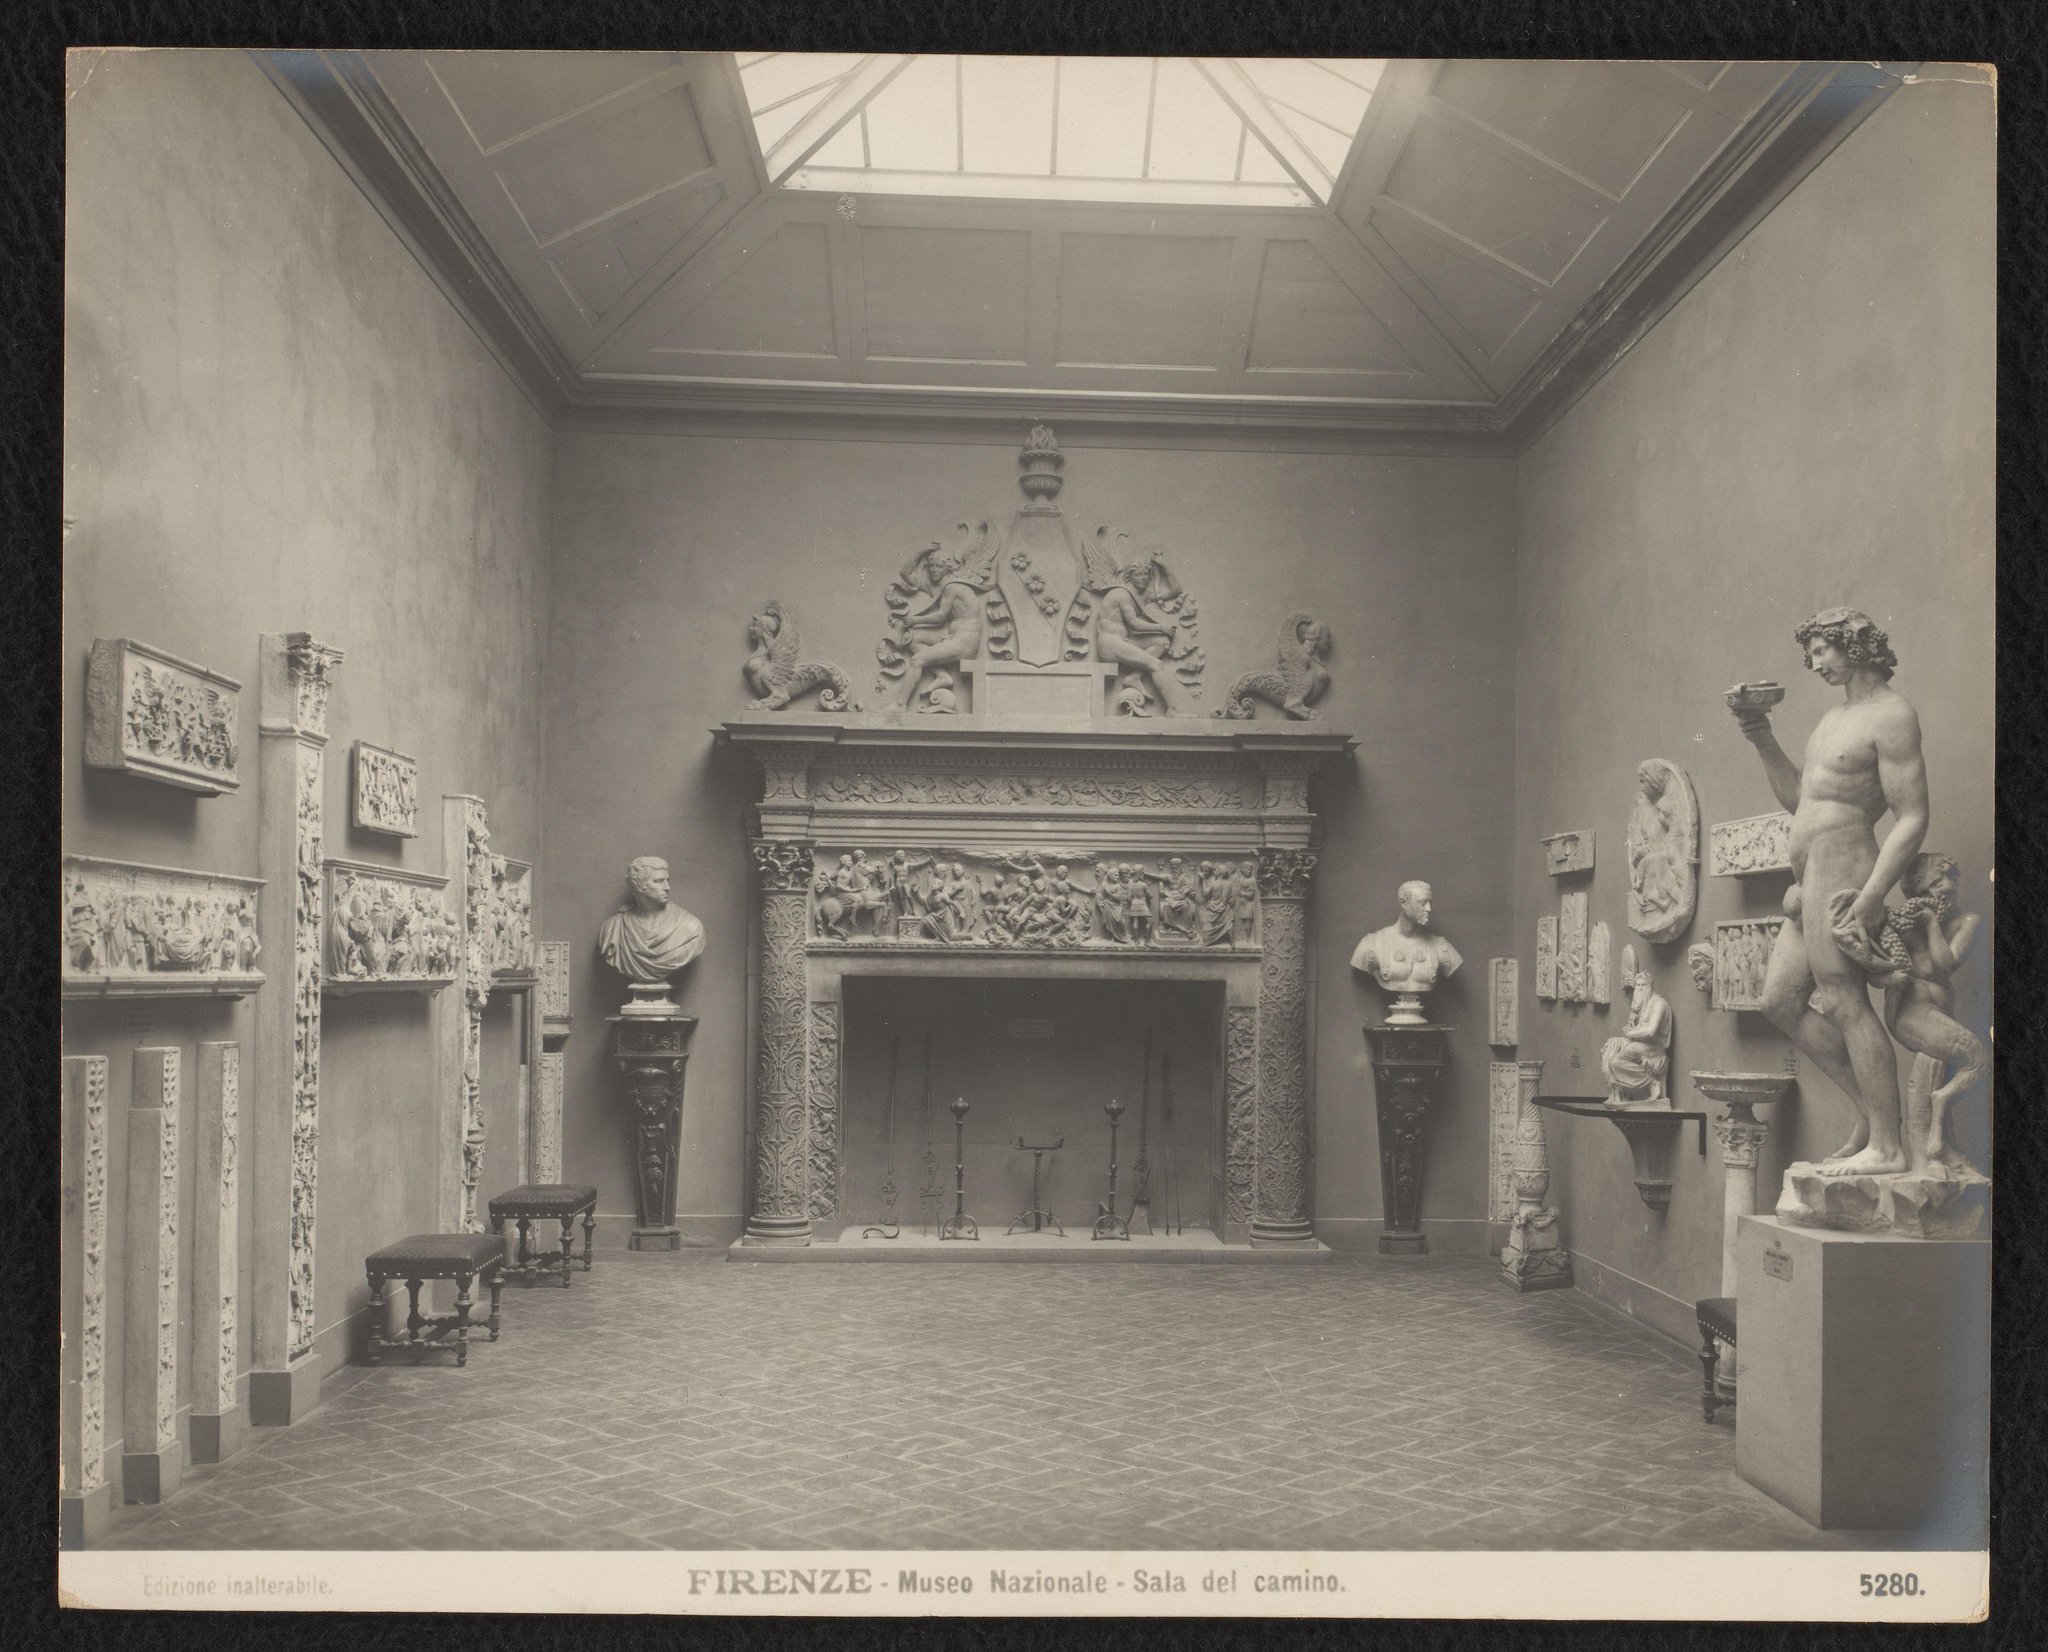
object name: photograph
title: Interieur van de Sala del camino in het Museo Nazionale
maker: Anonymous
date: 1901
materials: paper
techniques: gelatin silver print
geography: florence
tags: permanent exhibition, museum, interior ~ representation of a building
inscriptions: collector's mark: ‘RIJKS SCHOOL VOOR KUNSTNIJVERHEID/ GROEP’, inscription: ‘Edizione inalterabile.’, number: ‘5280.’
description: Deze foto maakt deel uit van een omslag.